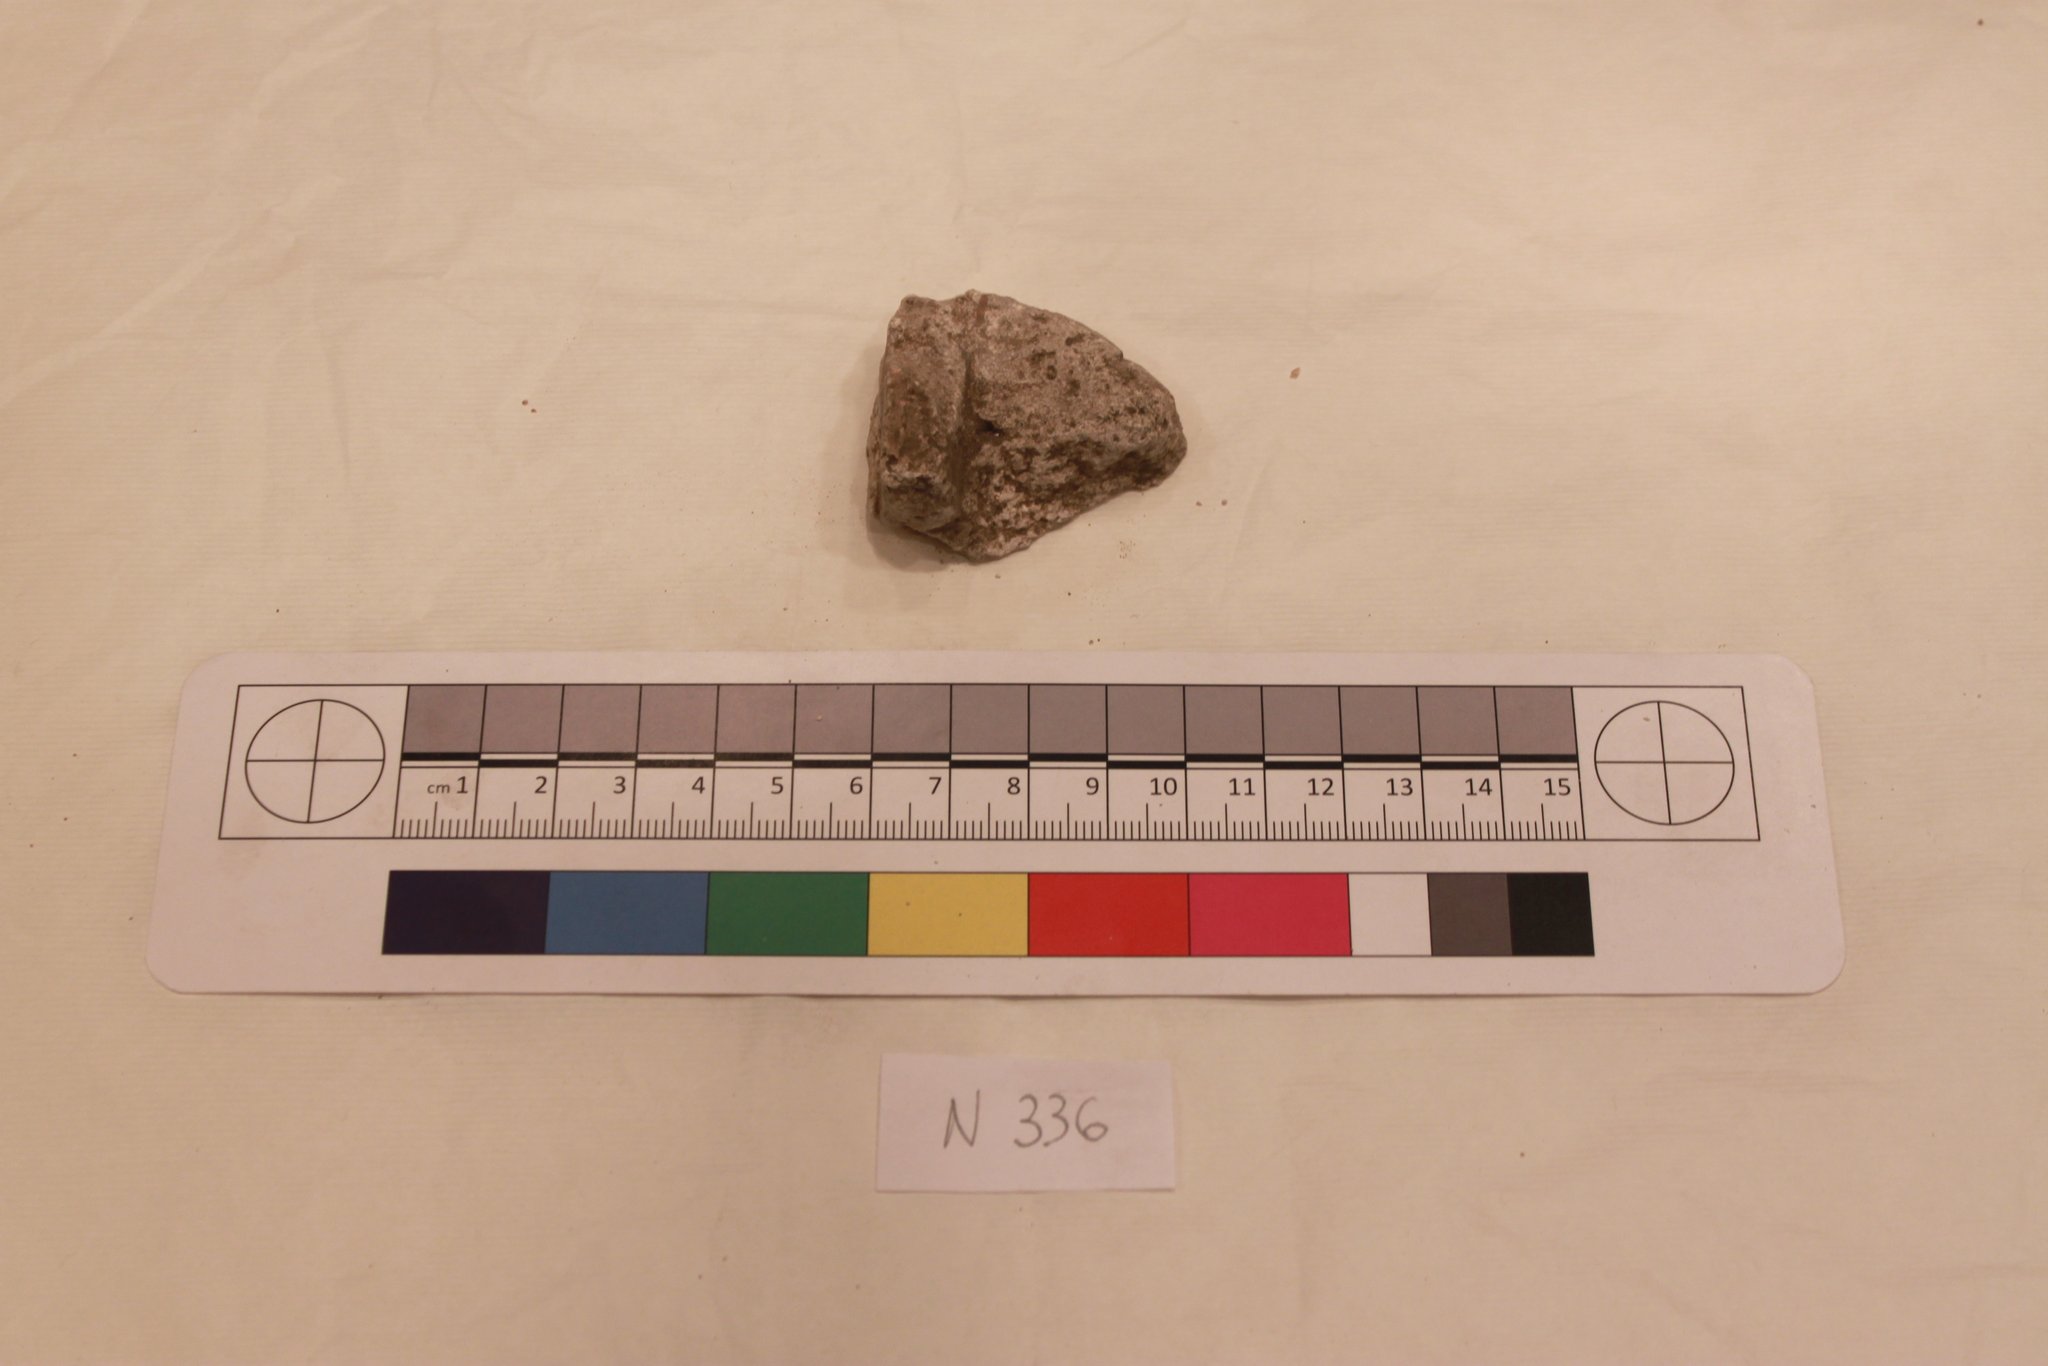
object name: fragment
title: Stucco Fragment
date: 701-1200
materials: plaster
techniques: carving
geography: iran